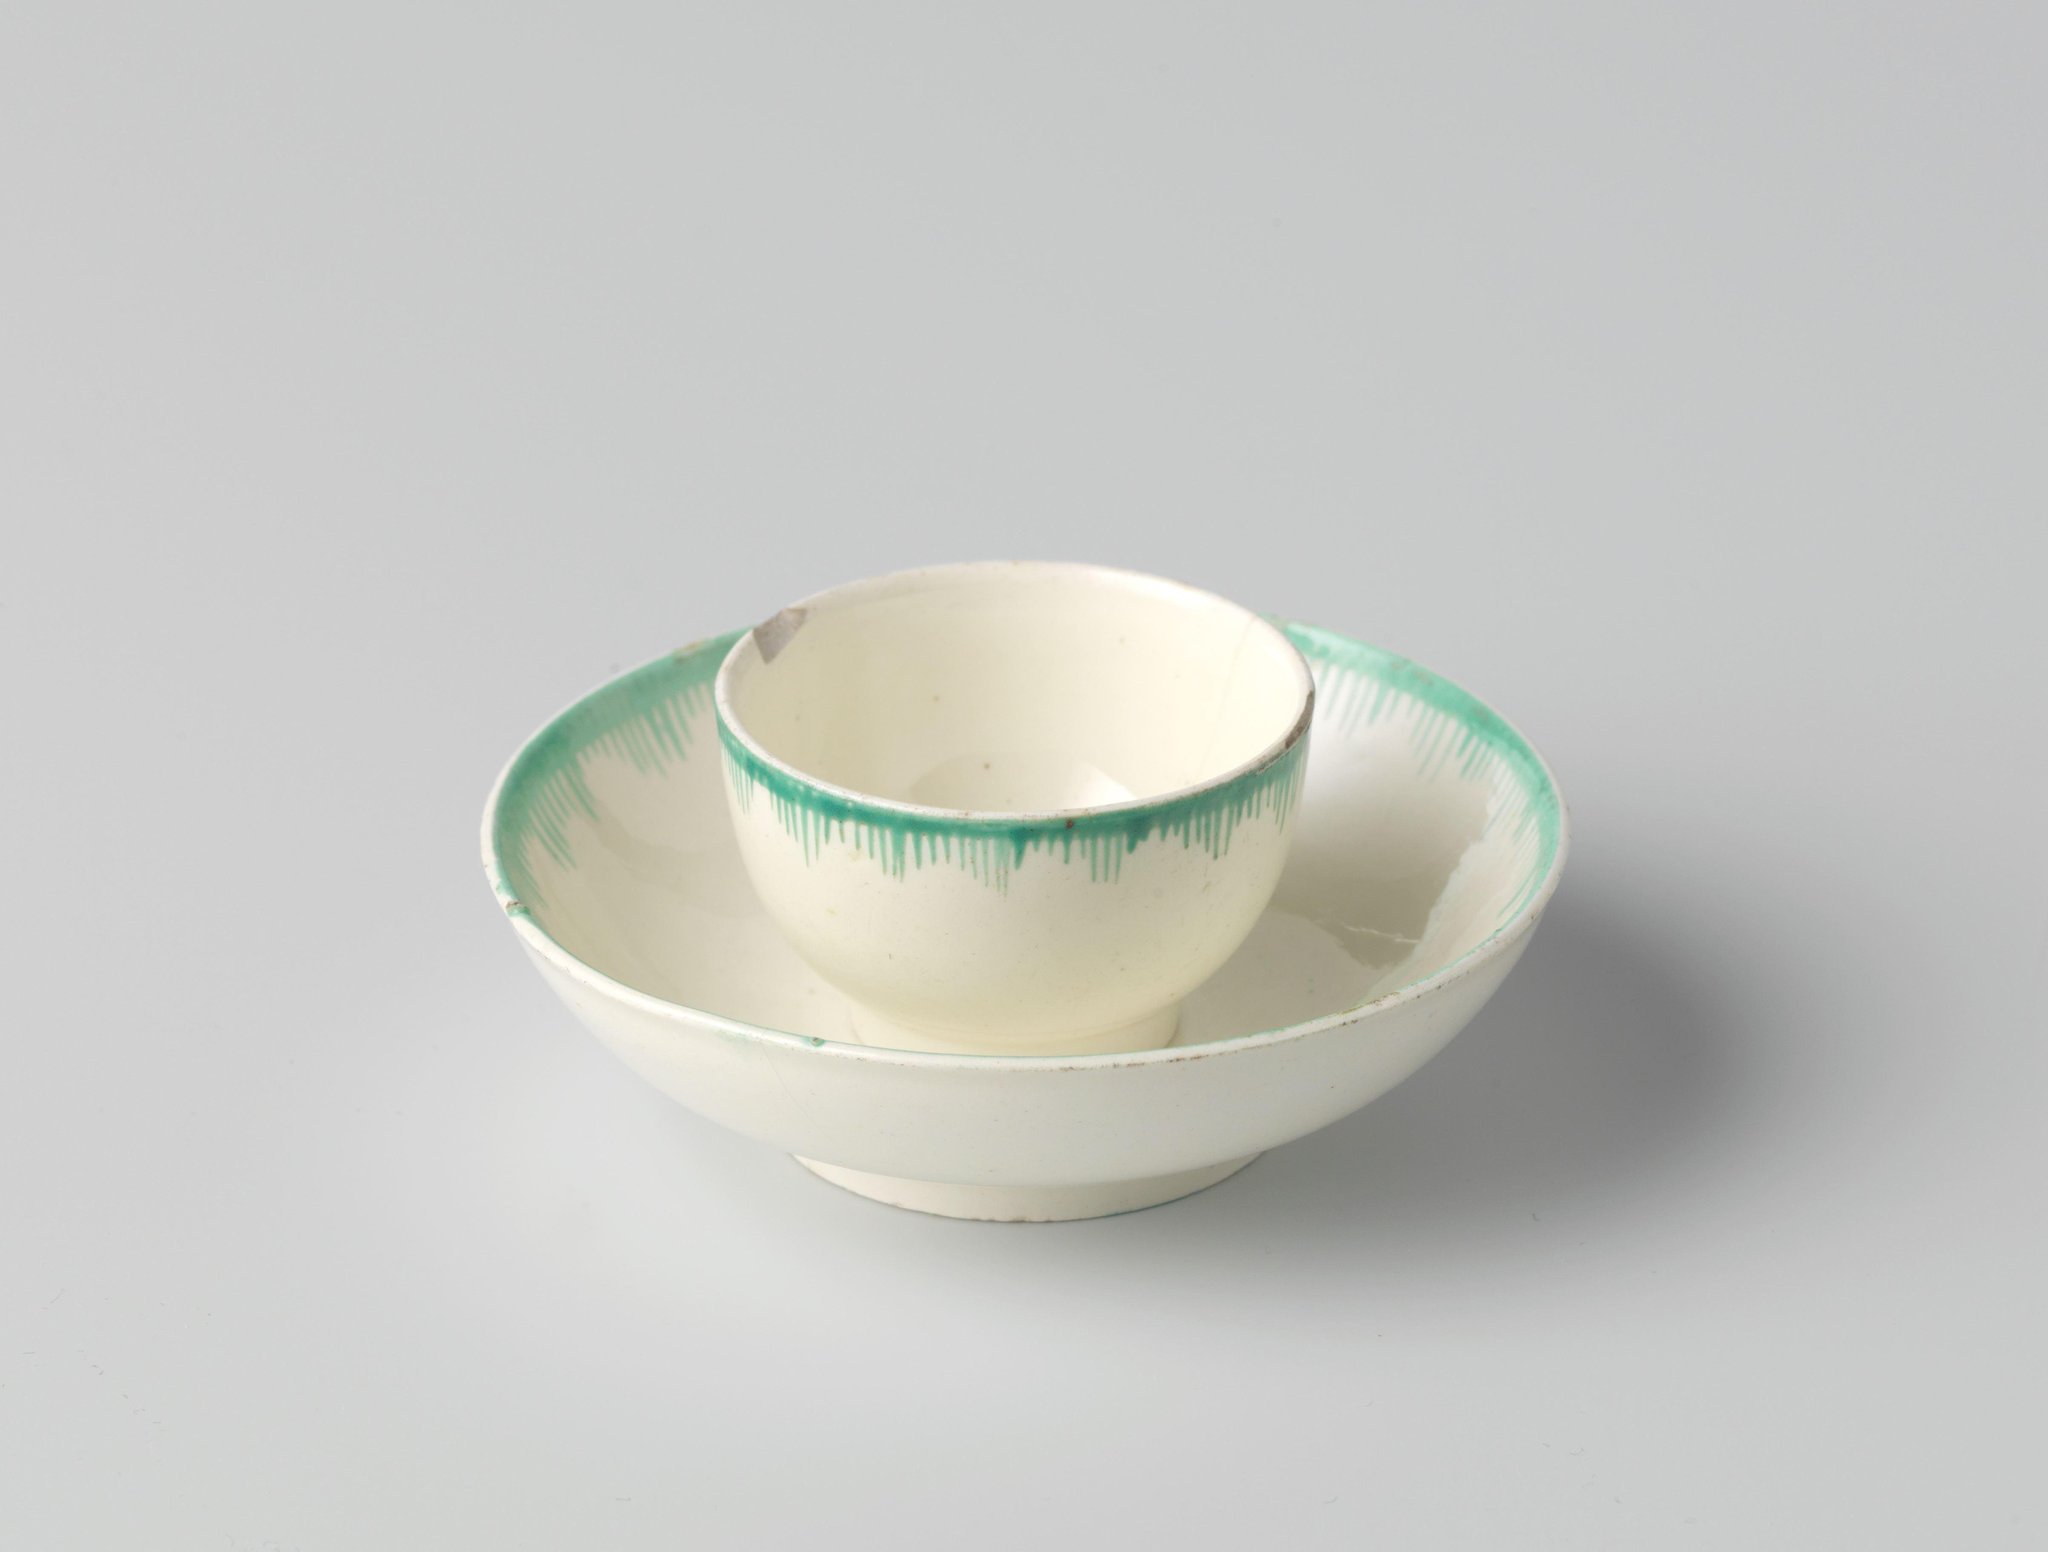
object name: cup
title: Kop van hardgebakken aardewerk, creamware.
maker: Anonymous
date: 1790-1810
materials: earthenware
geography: england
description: Kop van hardgebakken aardewerk, van een kinderservies. Kop heeft een groene uitstralende rand.